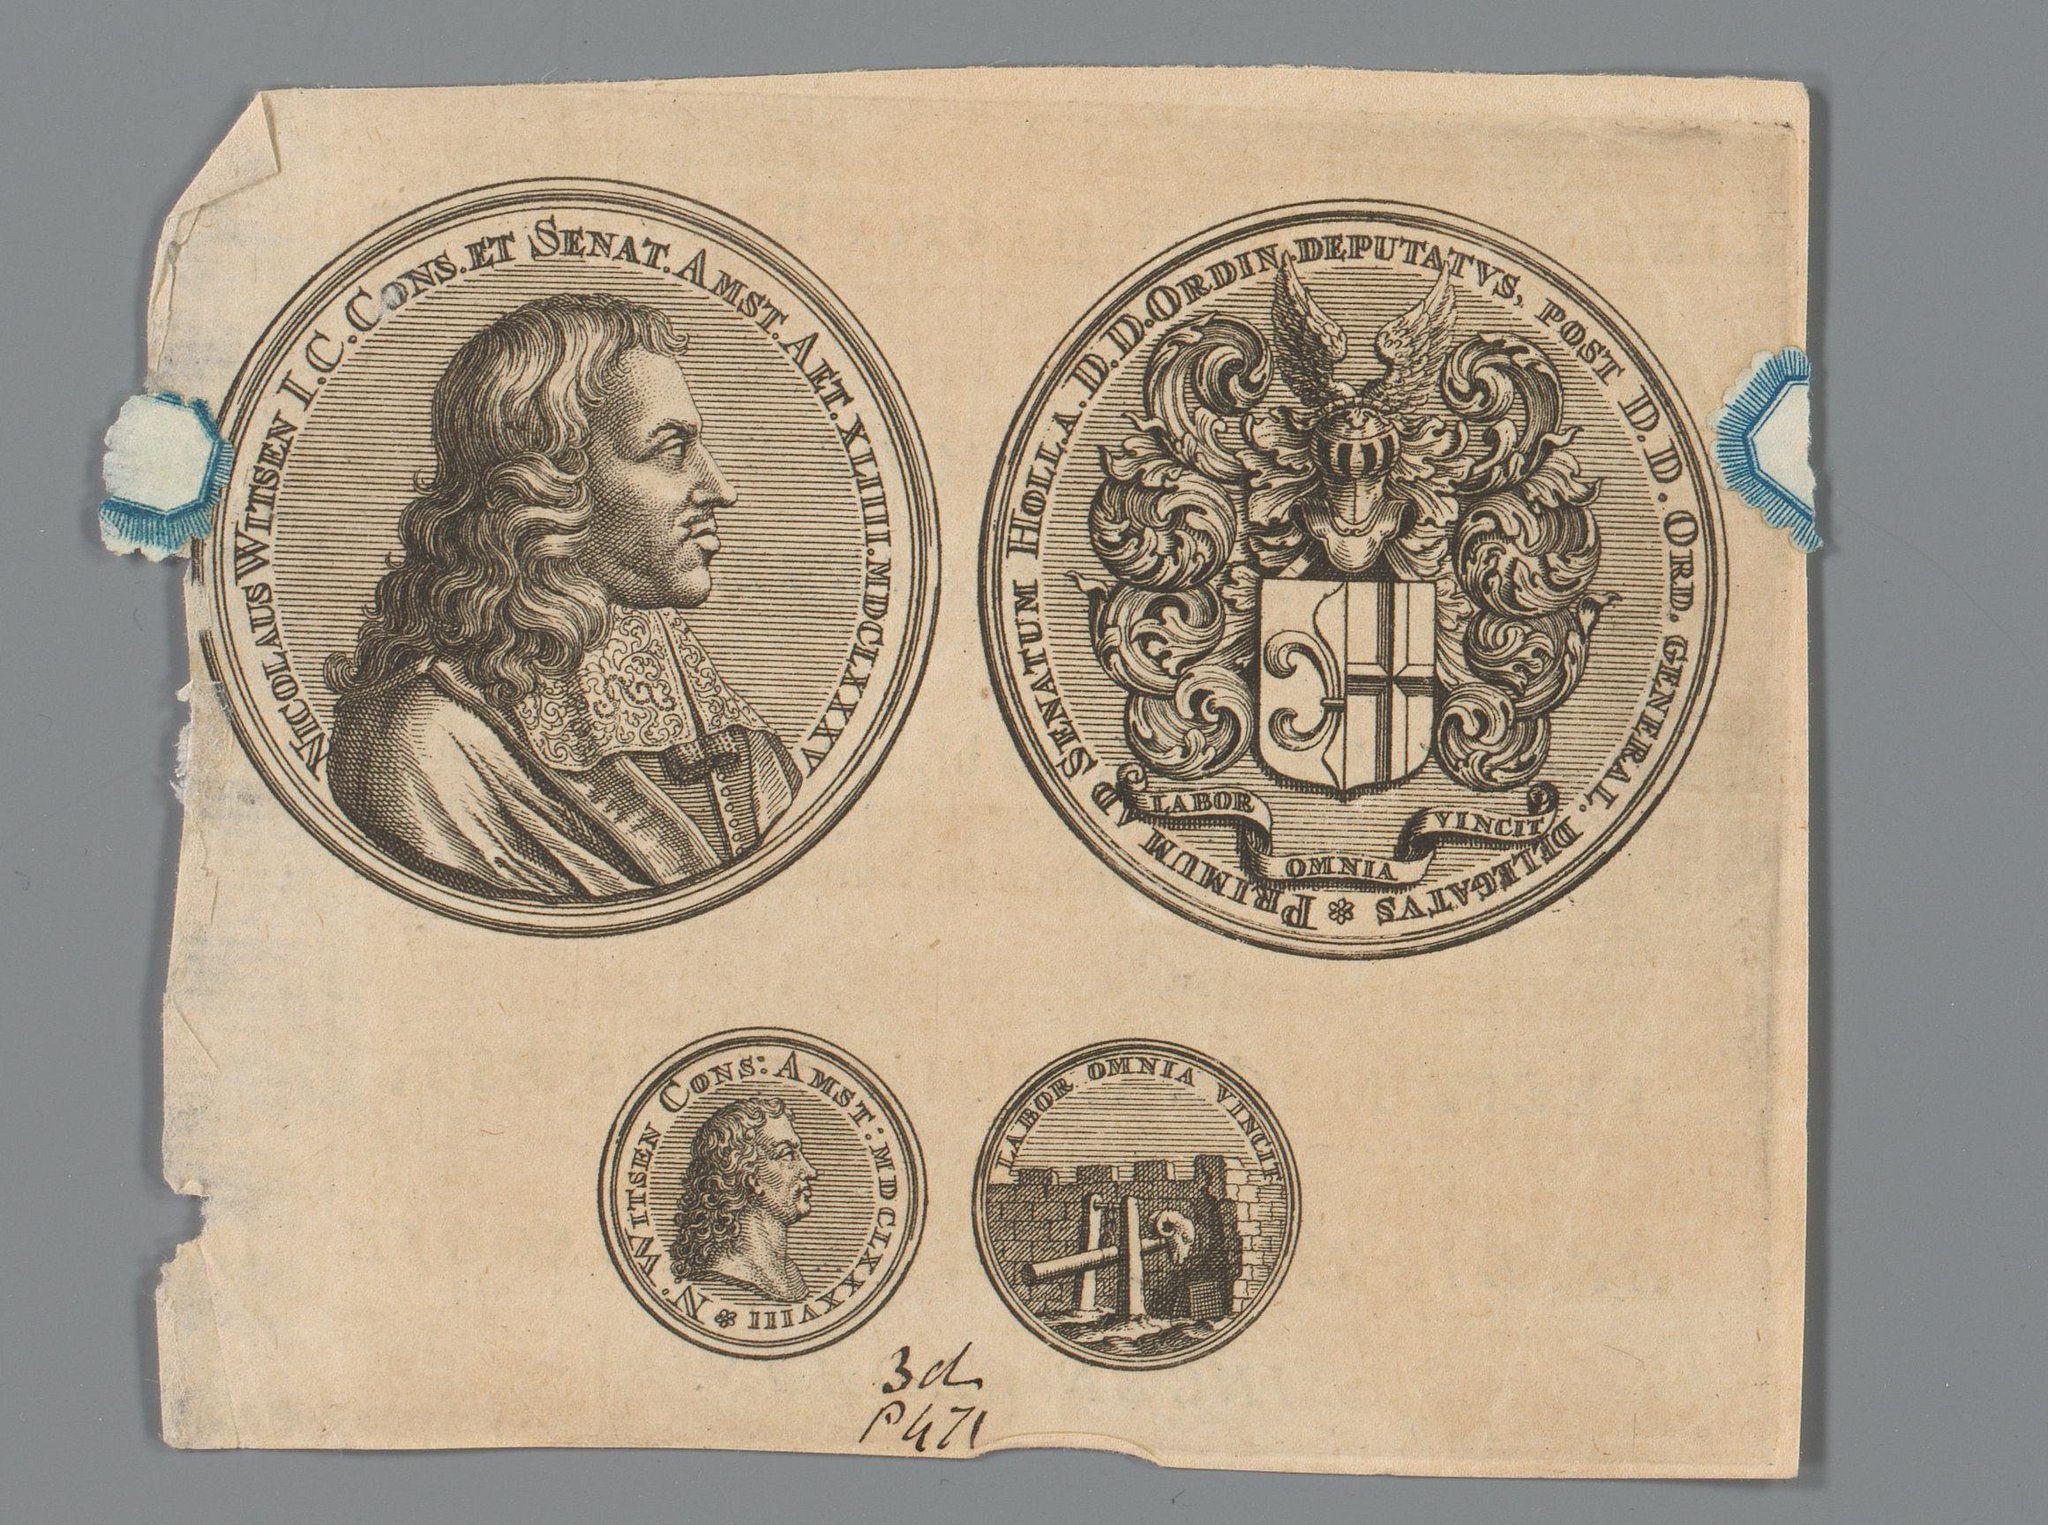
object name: book illustration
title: Voor- en achterzijden van twee penningen met daarop het portret van Nicolaes Cornelisz. Witsen, zijn wapen en een zinnebeeld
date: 1728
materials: paper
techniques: etching, letterpress printing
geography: the hague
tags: amsterdam, print maker, mayor, nicolaes cornelisz. witsen, coat of arms (symbol of sovereignty), mayor, burgomaster, historical persons, coin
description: Prent uit: Loon, Gerard van. Beschryving der Nederlandsche Historipenningen: (...). Den Haag: Christiaan van Lom et al., 1728, dl. 3, p. 470.